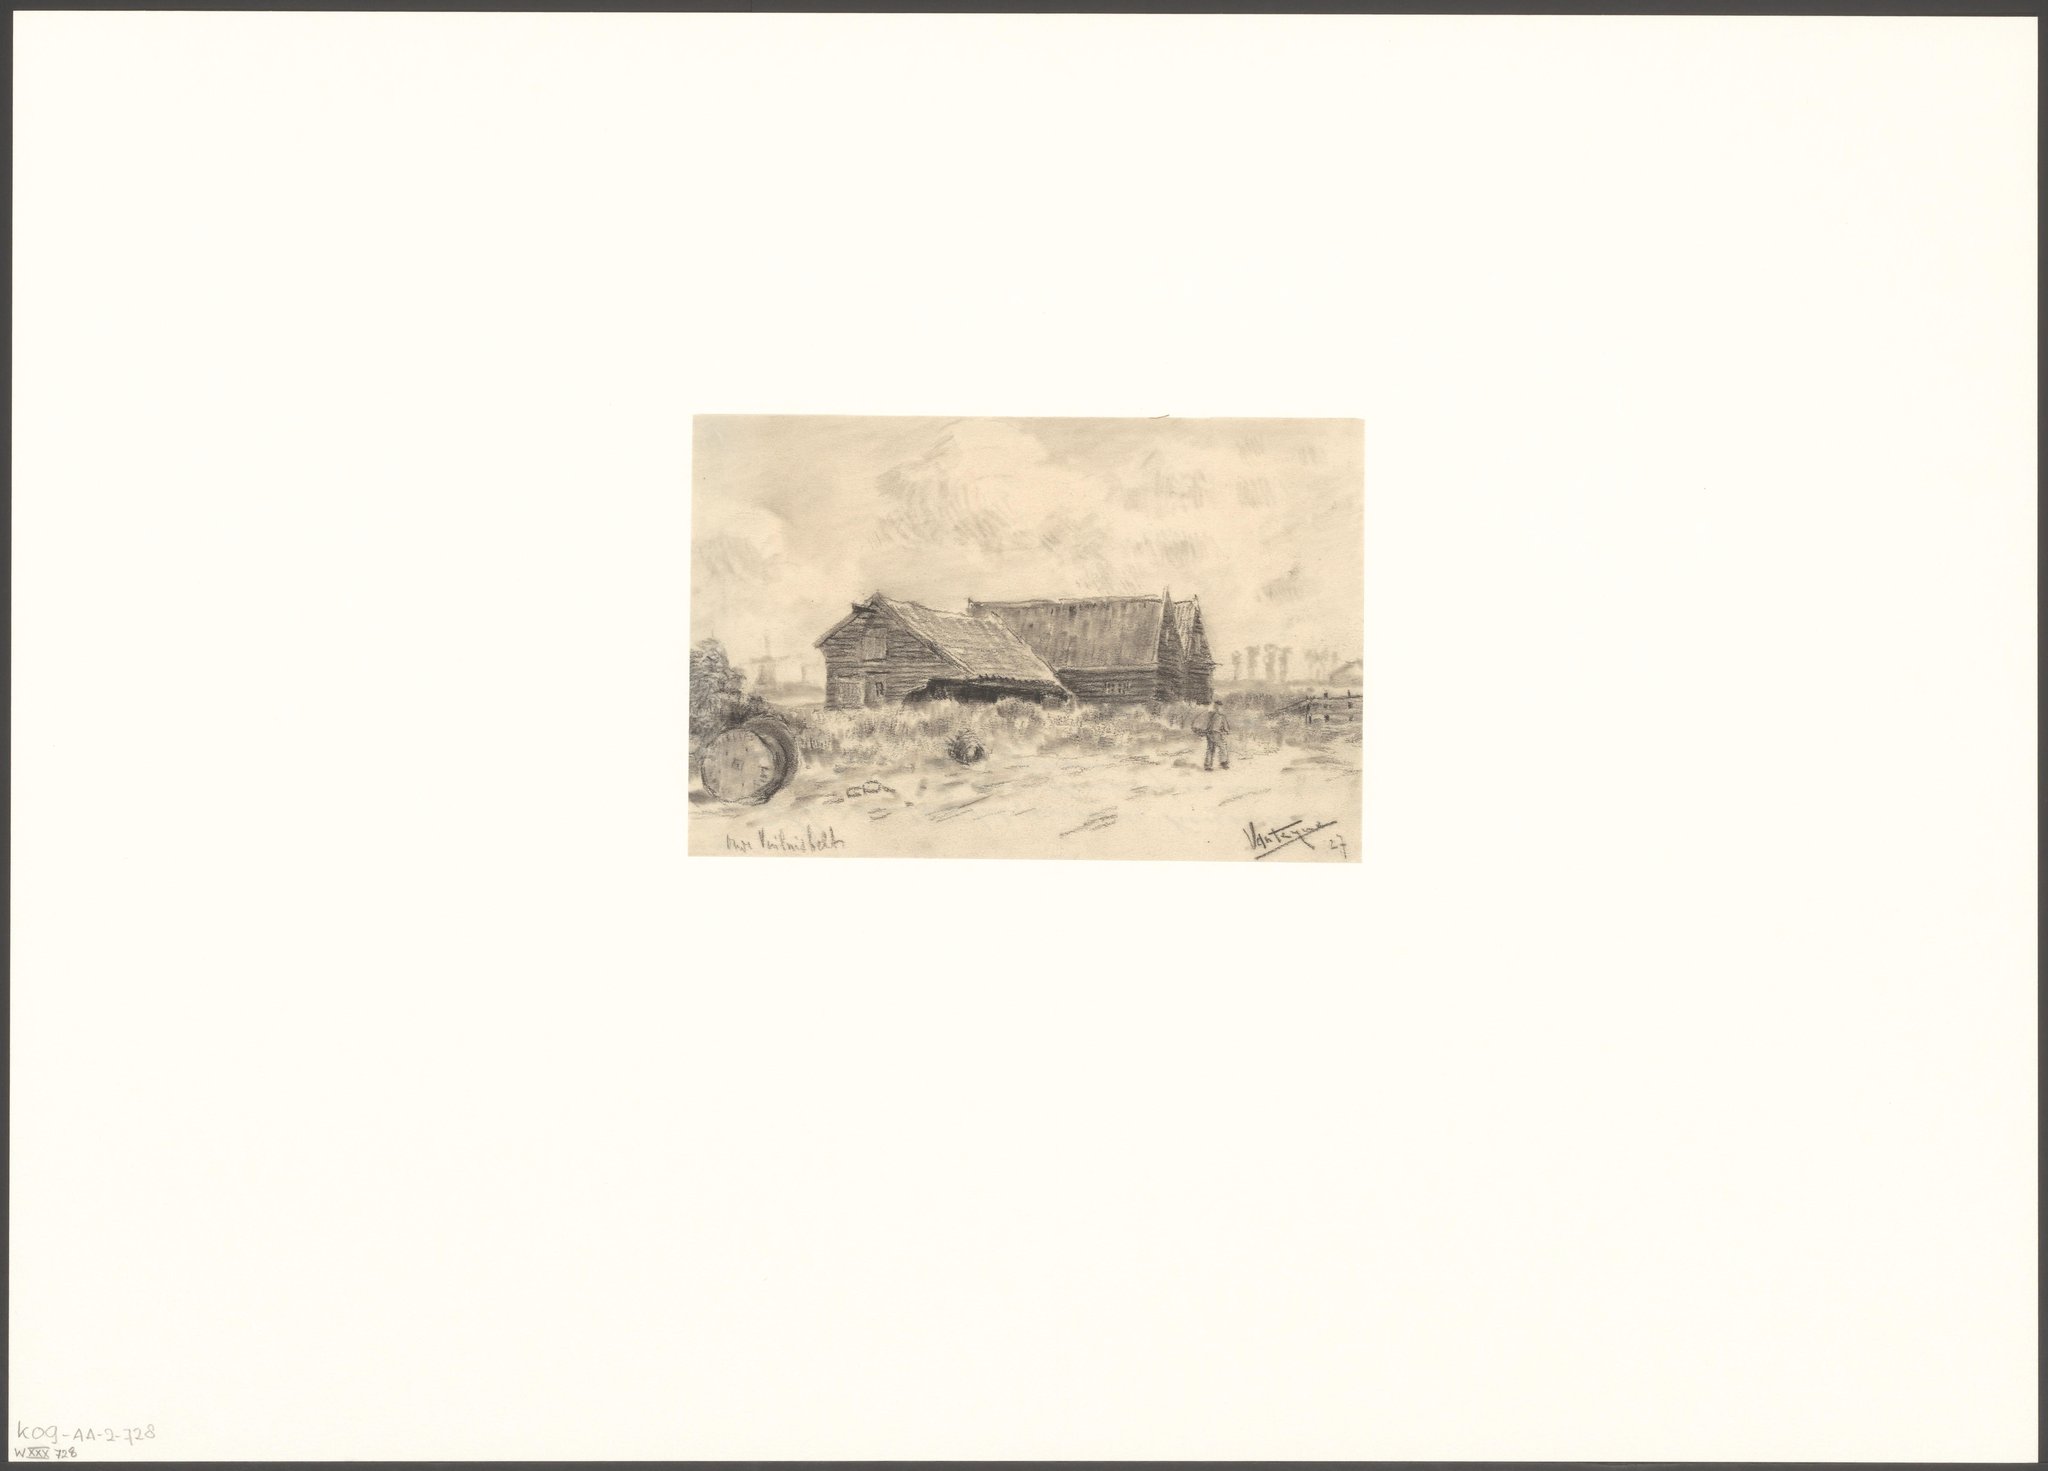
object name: drawing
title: Gezicht op de voormalige vuilnisbelt bij de Buyskade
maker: anthonie van teijn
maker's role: draughtsman, painter, print maker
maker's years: 1863-1943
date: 1907-1927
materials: chalk, paper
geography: amsterdam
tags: tower, clock tower ~ monumental adornment, city-view in general; 'veduta', canal, garbage collection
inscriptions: signature and date: ‘VanTeyne / 27’, inscription: ‘oude Vuilnisbelt’, inscription: ‘Stadvuilnisbelt aan de (...) Juli 1927 / vanEck’, collector's mark: Lugt 800a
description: Tekening binnen de Atlas Van Eck ingedeeld op wijknummer 30.